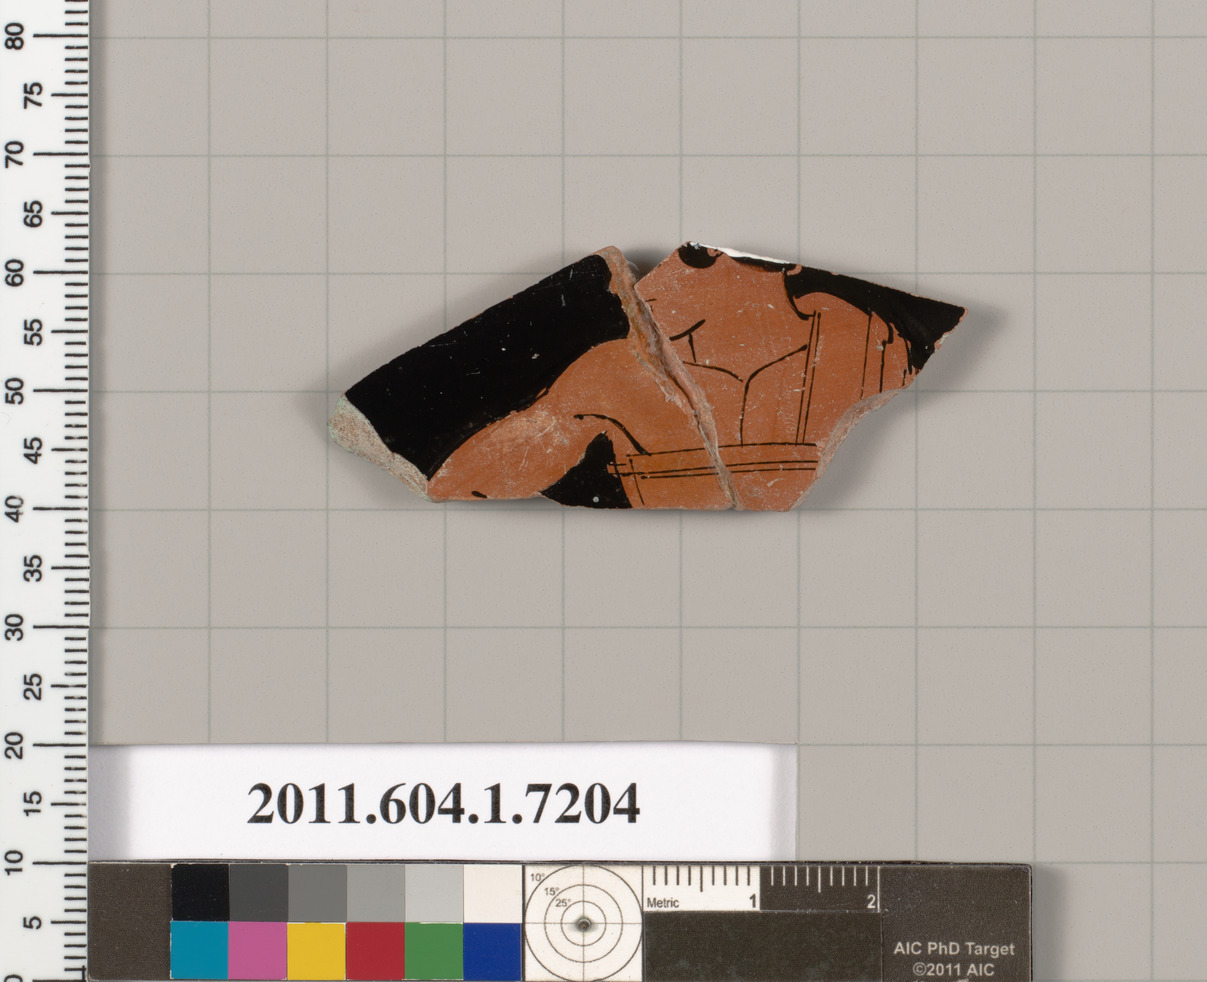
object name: kylix fragment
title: Terracotta fragment of a kylix (drinking cup)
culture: greek, attic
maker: makron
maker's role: artist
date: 500-480 BCE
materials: terracotta